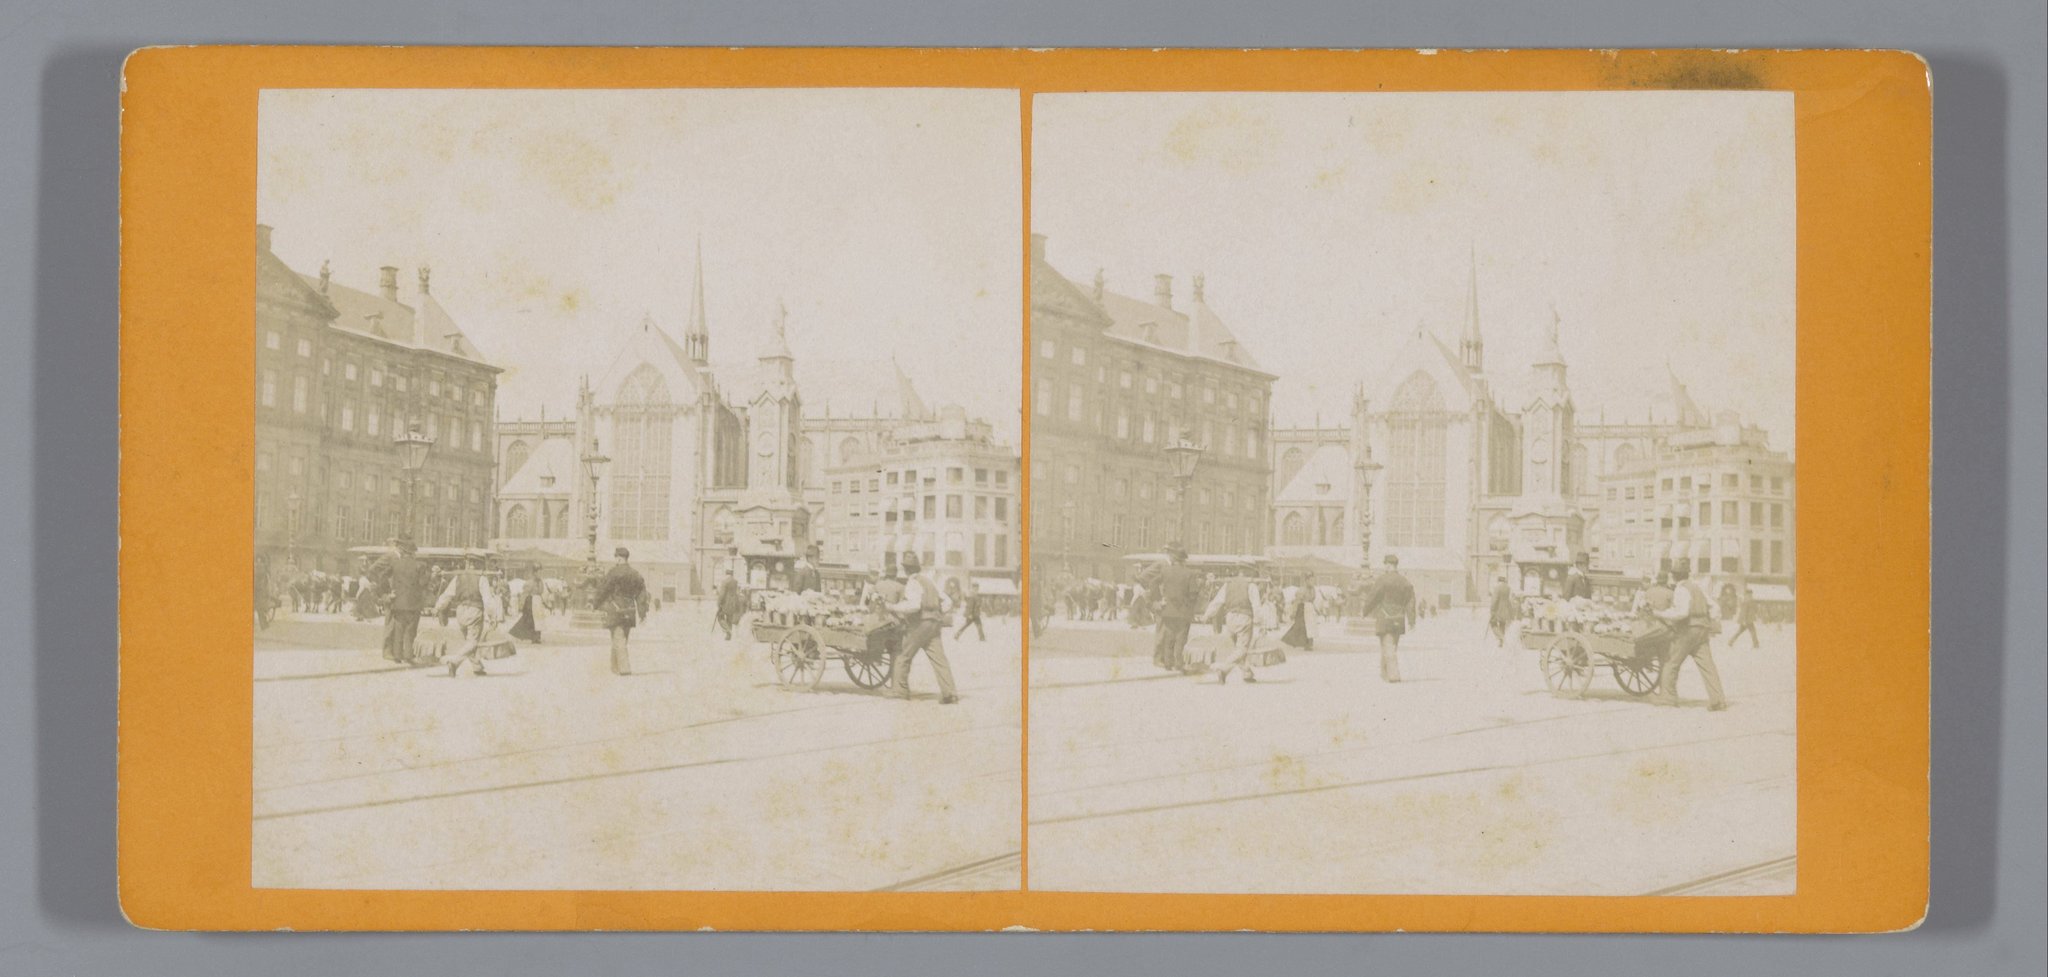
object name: stereograph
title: Gezicht op de Dam, Amsterdam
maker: Anonymous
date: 1860-1880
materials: cardboard, paper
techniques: albumen print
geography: amsterdam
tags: square, place, circus, etc., royal palace of amsterdam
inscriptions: inscription: ‘Amsterdam/ Dam/ 153’